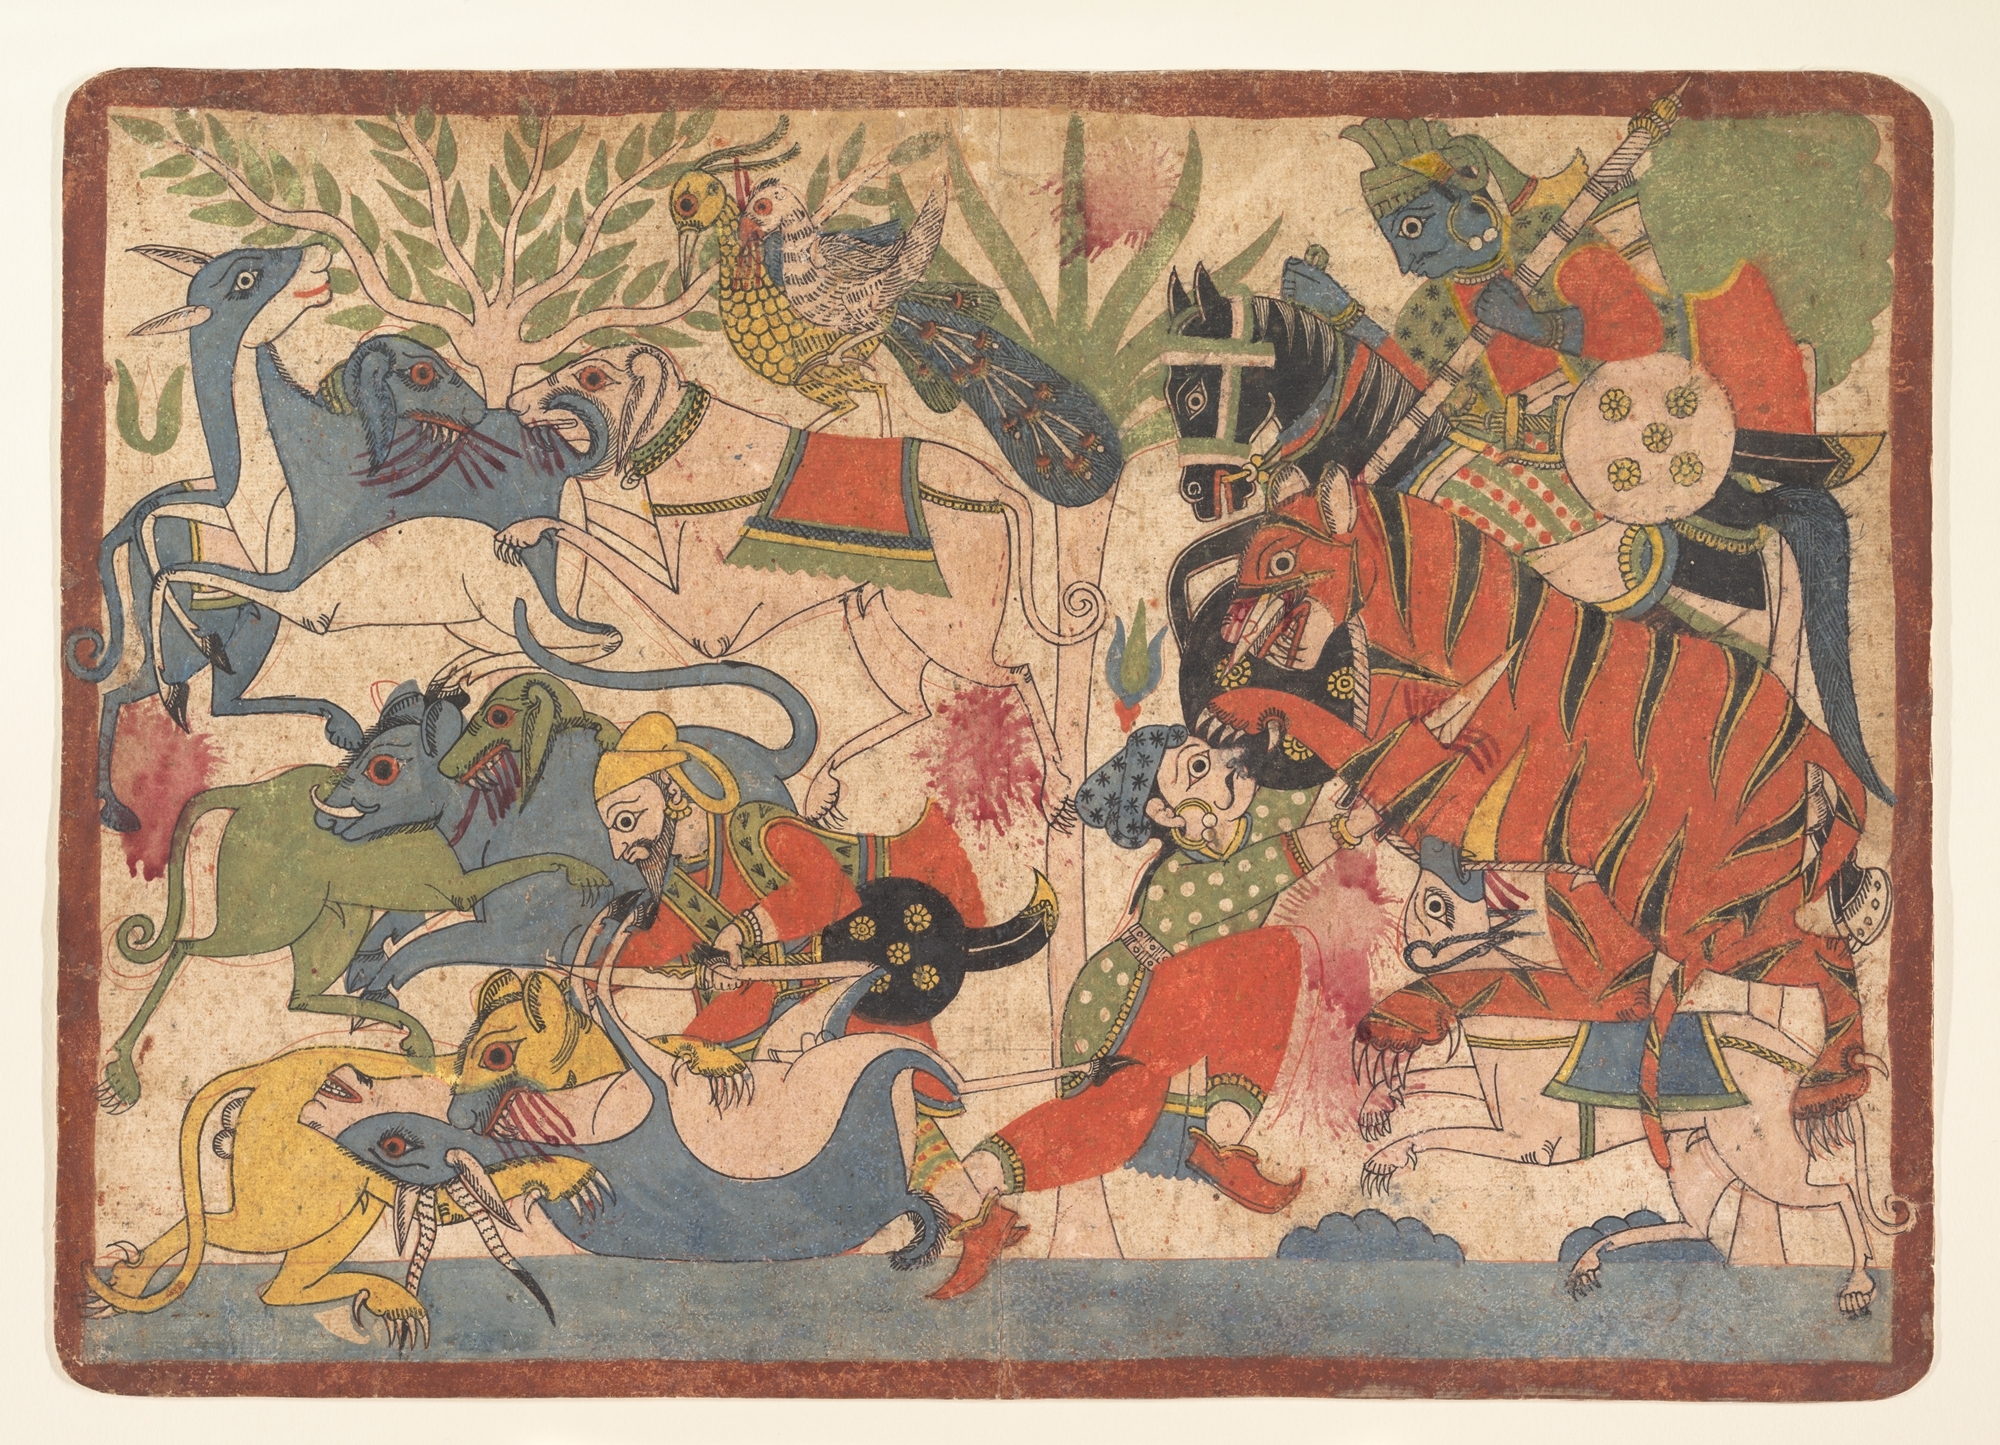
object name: folio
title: “Royal Hunt,” folio from a Mahabharata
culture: western indian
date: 1800-1850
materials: ink, paper, watercolor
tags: men,hunting,peacocks,horses,tigers